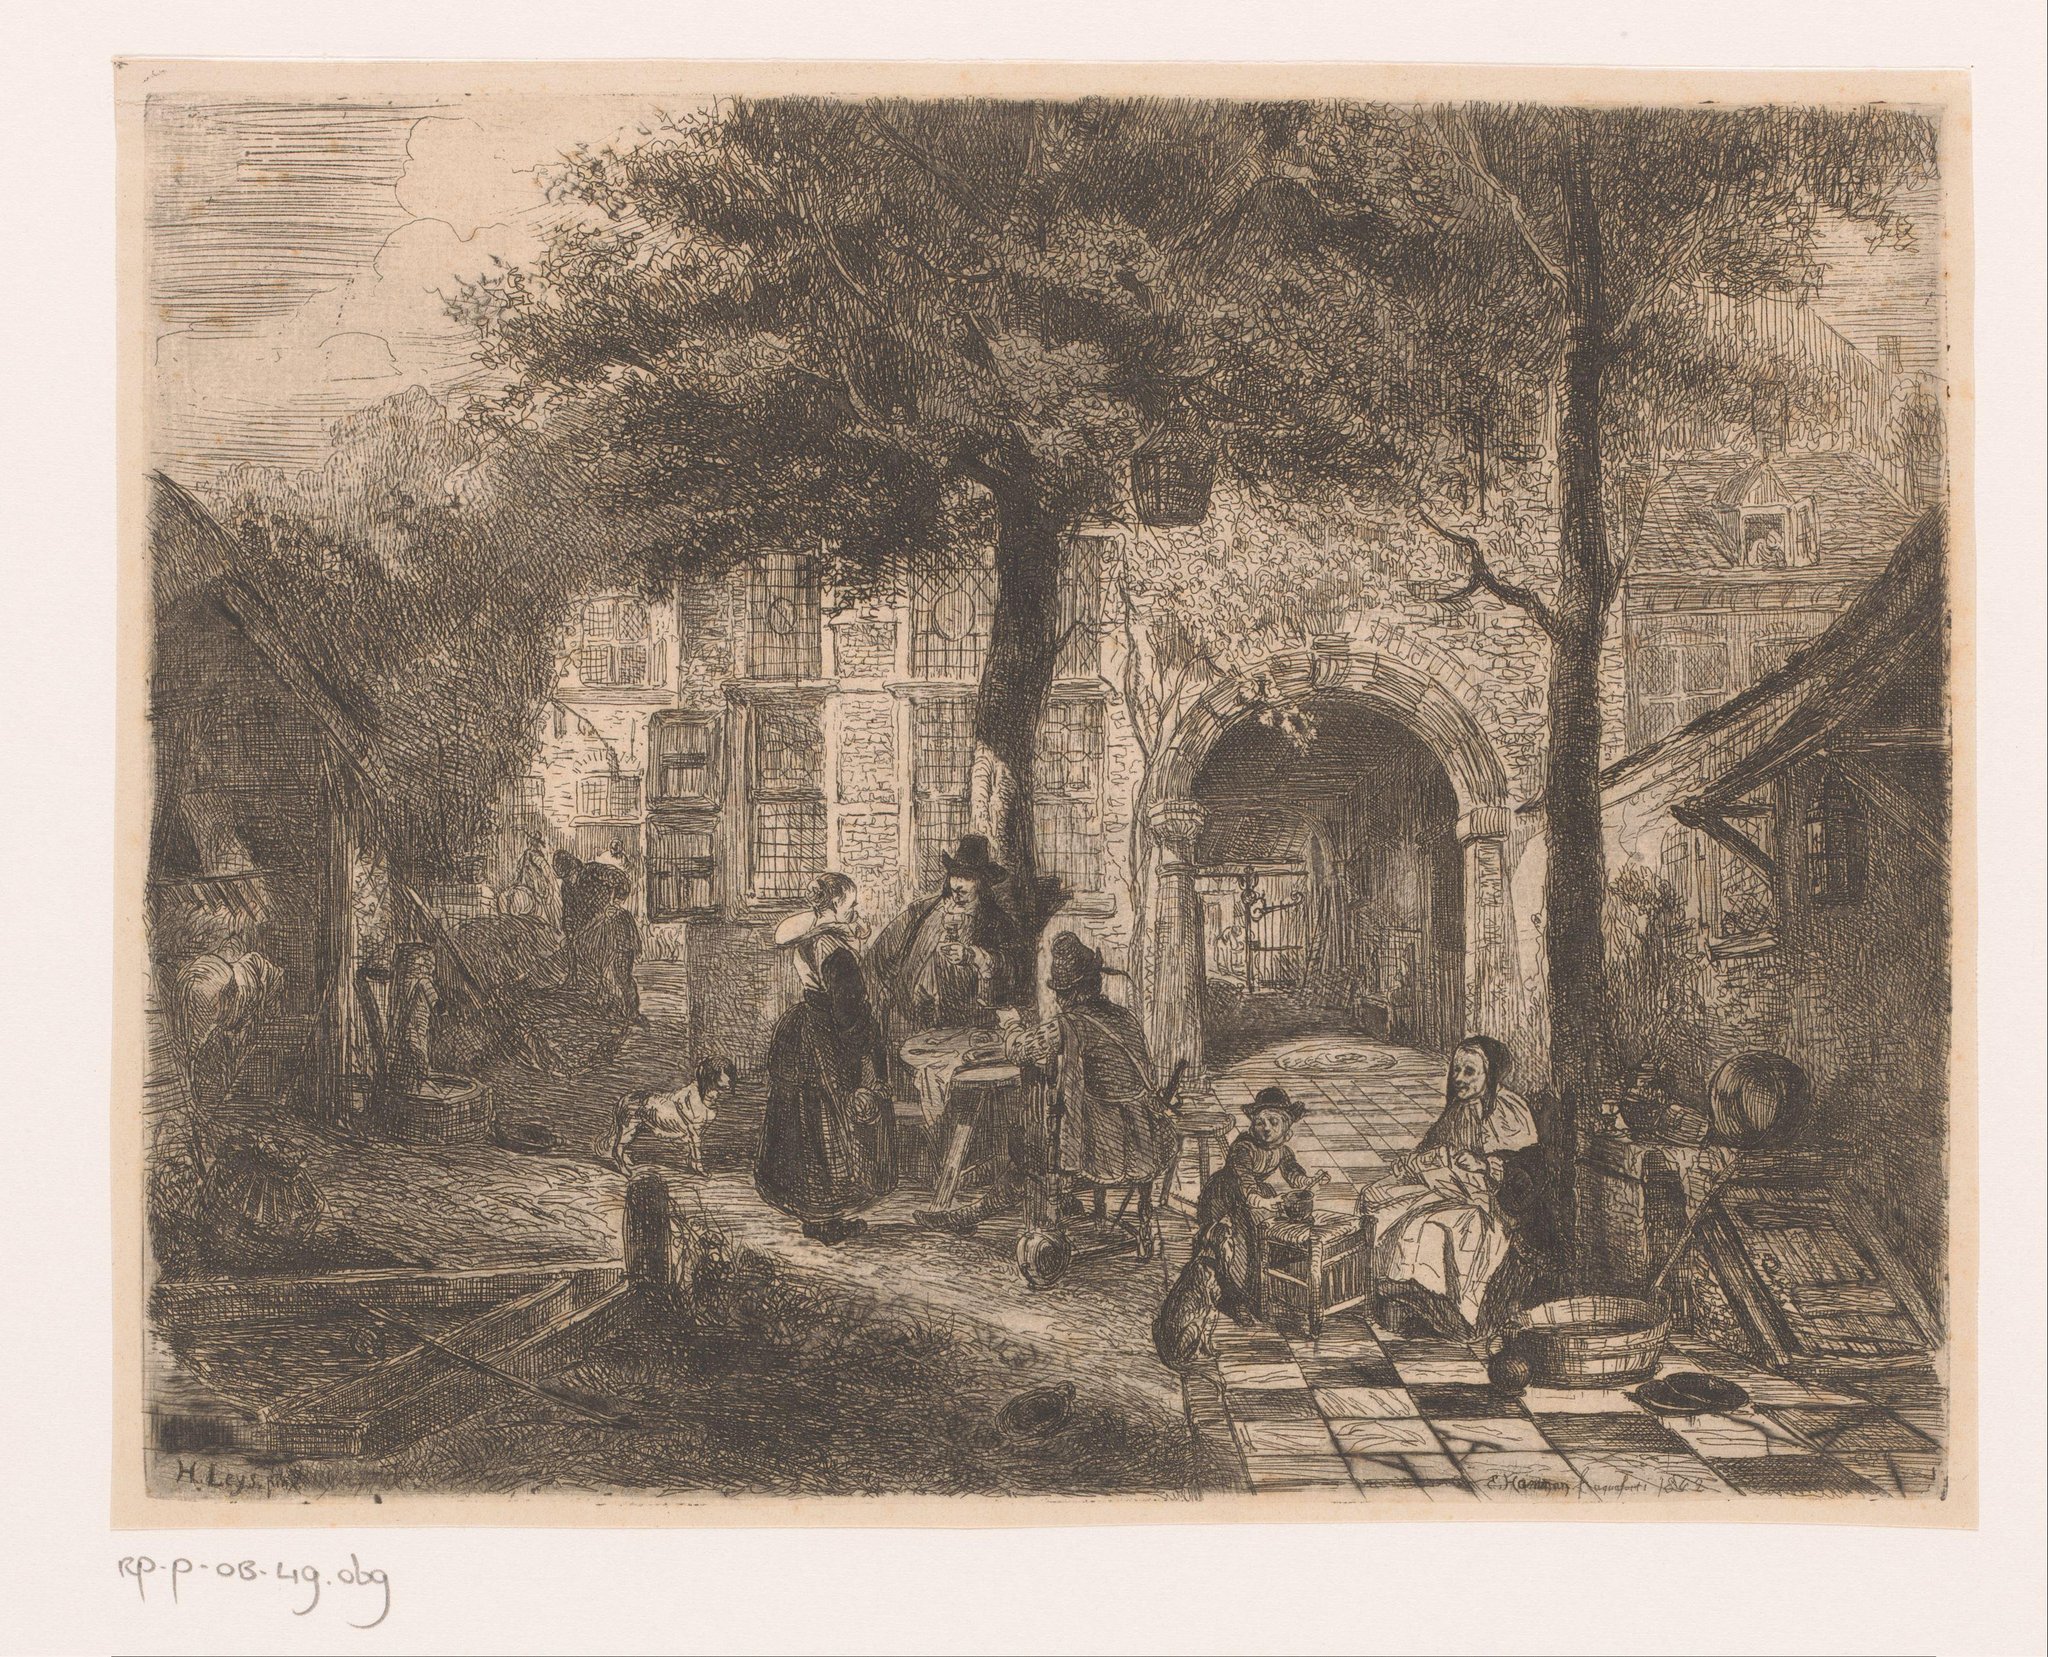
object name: print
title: Binnenplaats van een Vlaamse herberg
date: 1842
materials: paper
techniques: drypoint, etching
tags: inn, coffee-house, public house, etc., courtyard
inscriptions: date